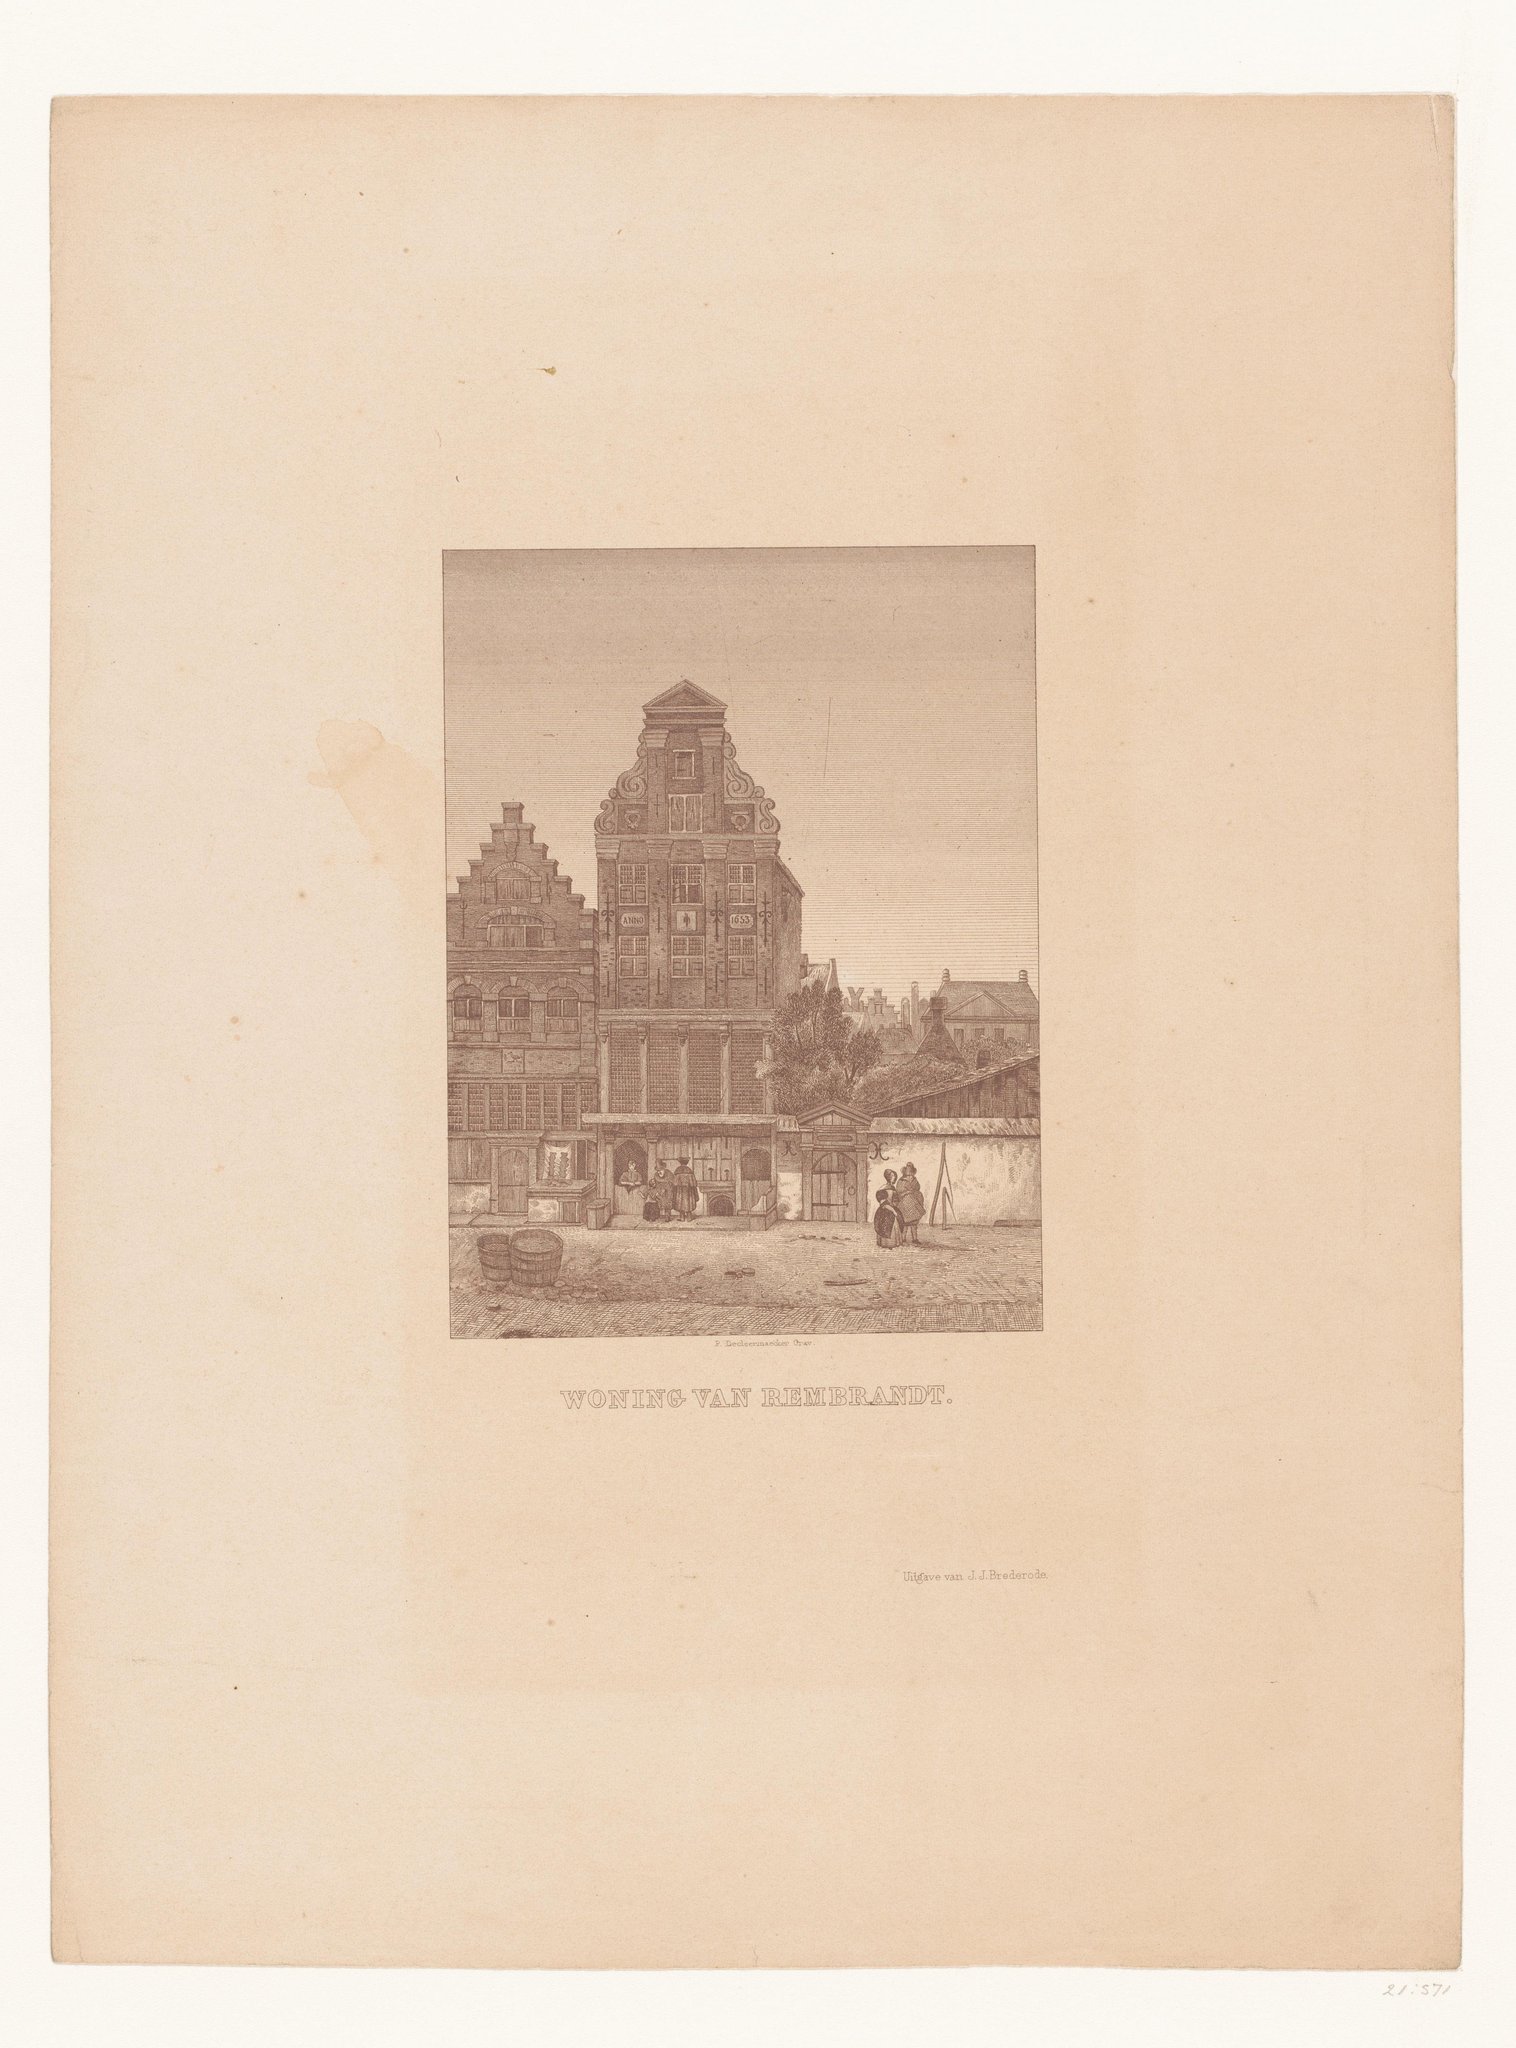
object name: print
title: Woning van Rembrandt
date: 1847-1883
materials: paper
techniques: engraving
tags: leiden, amsterdam, painter, print maker, draughtsman, rembrandt van rijn, housing, street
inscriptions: collector's mark: Lugt 2233